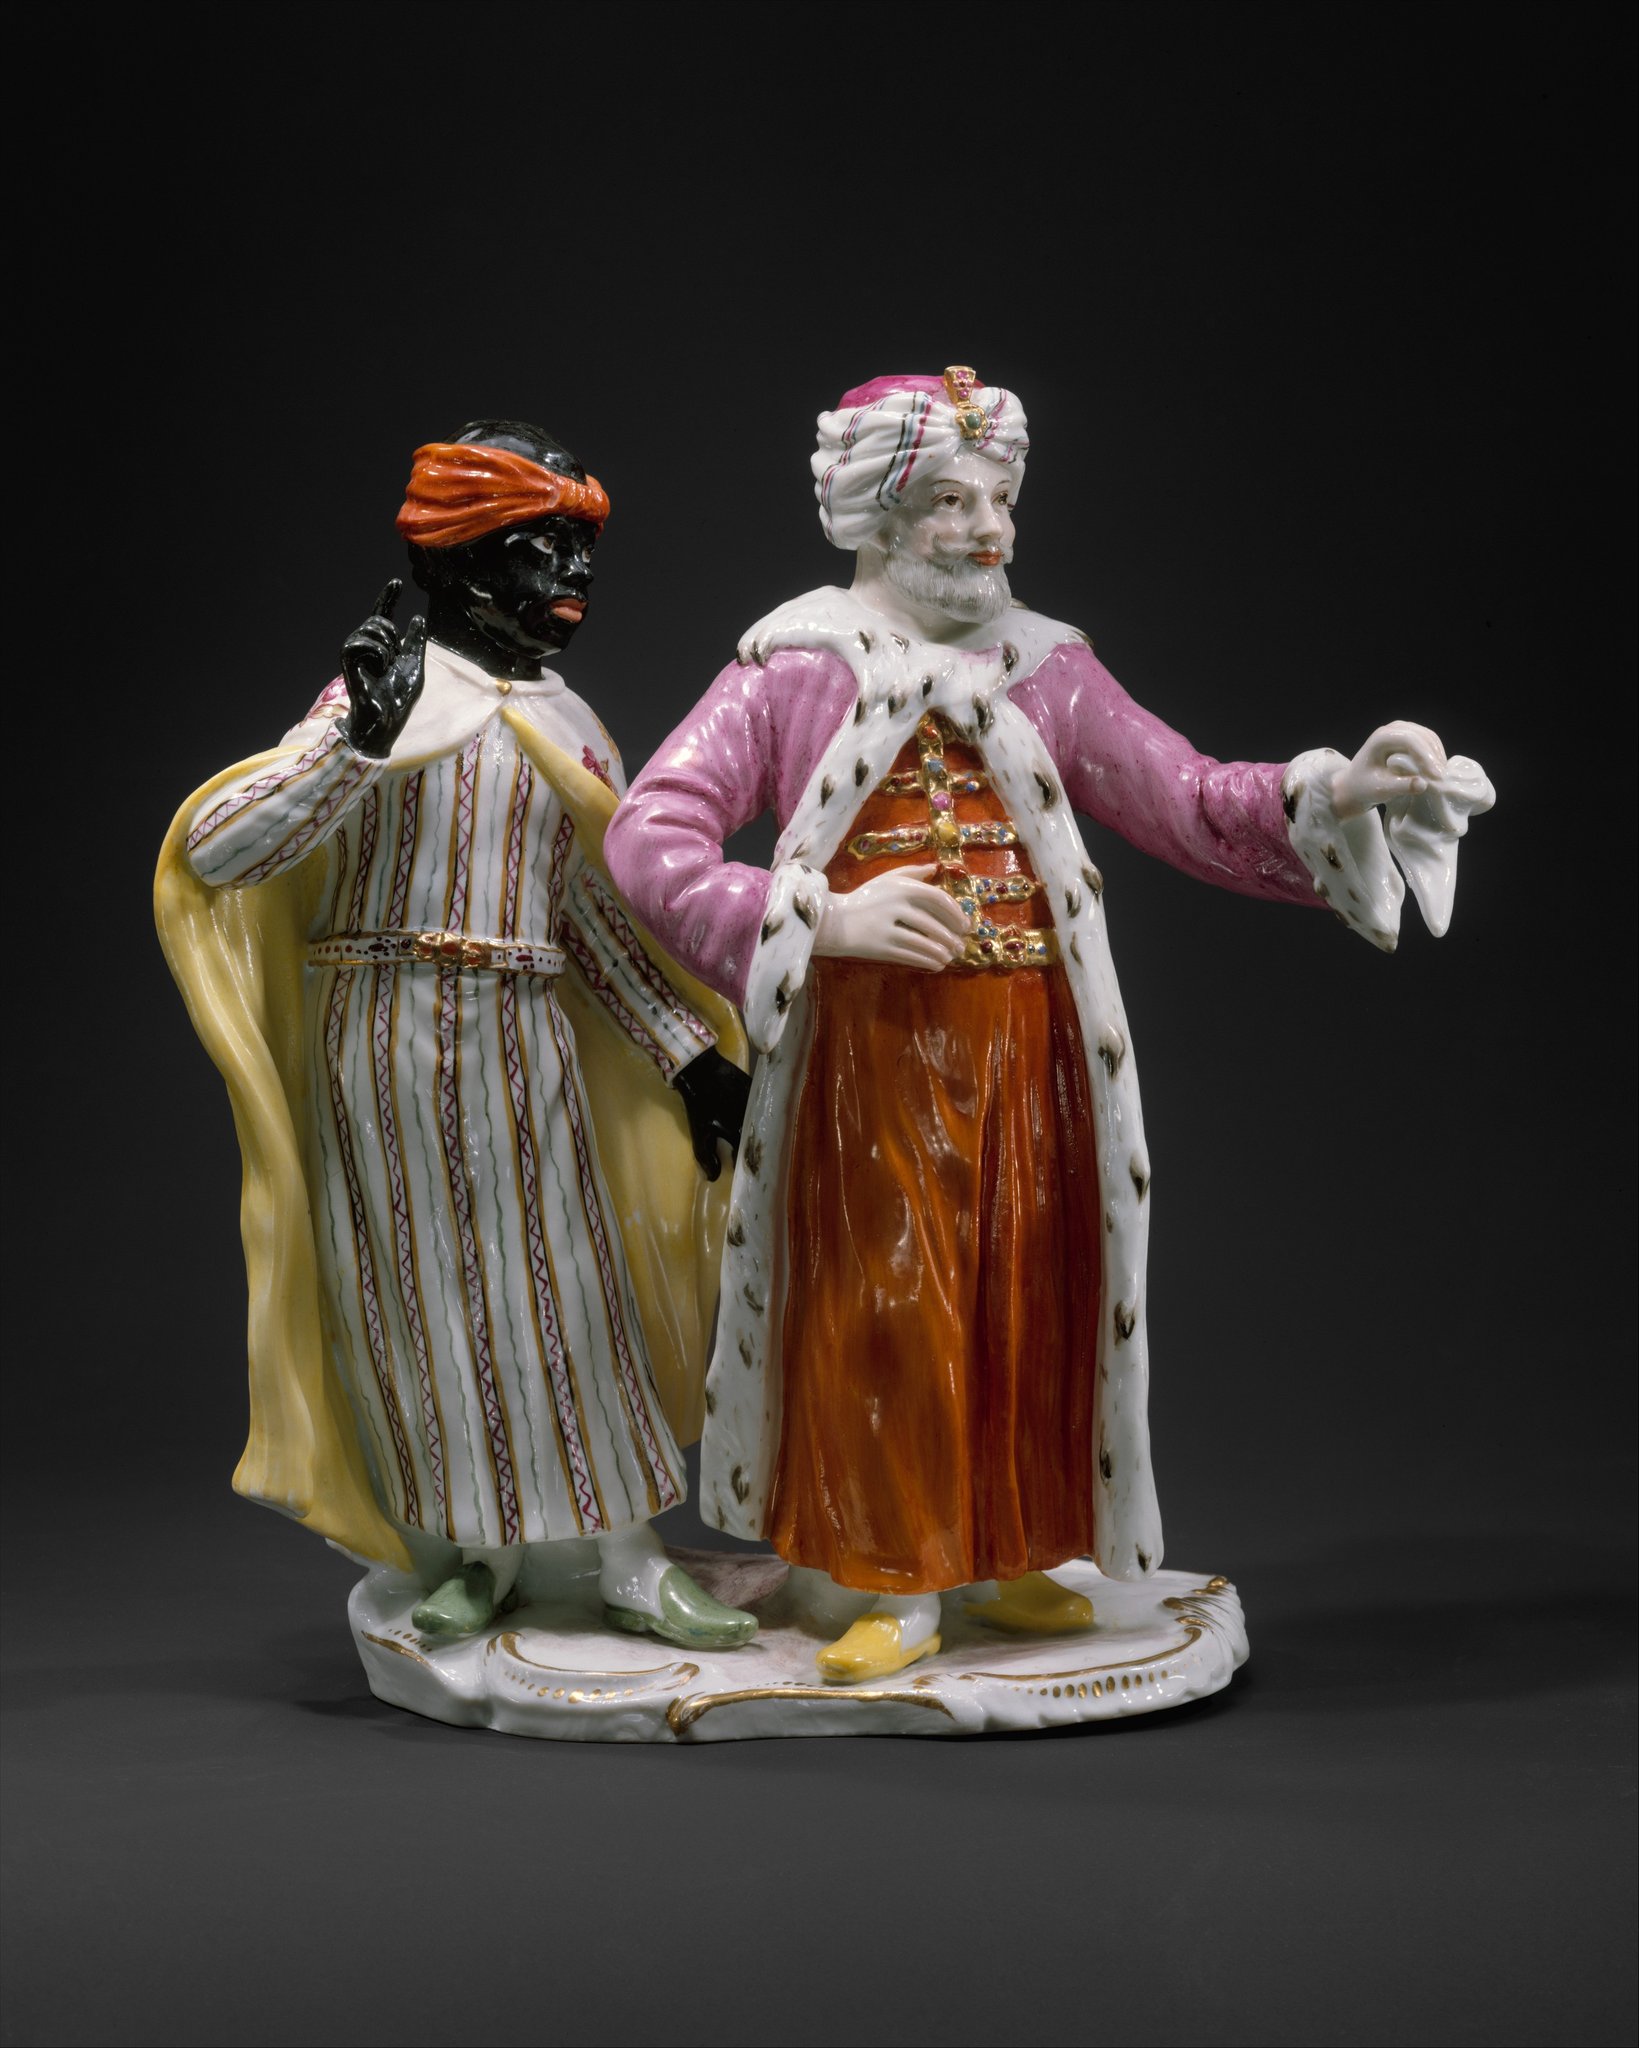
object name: group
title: Sultan and Moor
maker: fürstenberg porcelain manufactory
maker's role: manufactory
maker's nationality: german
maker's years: 1747-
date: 1773-1774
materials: hard paste porcelain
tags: kings,men